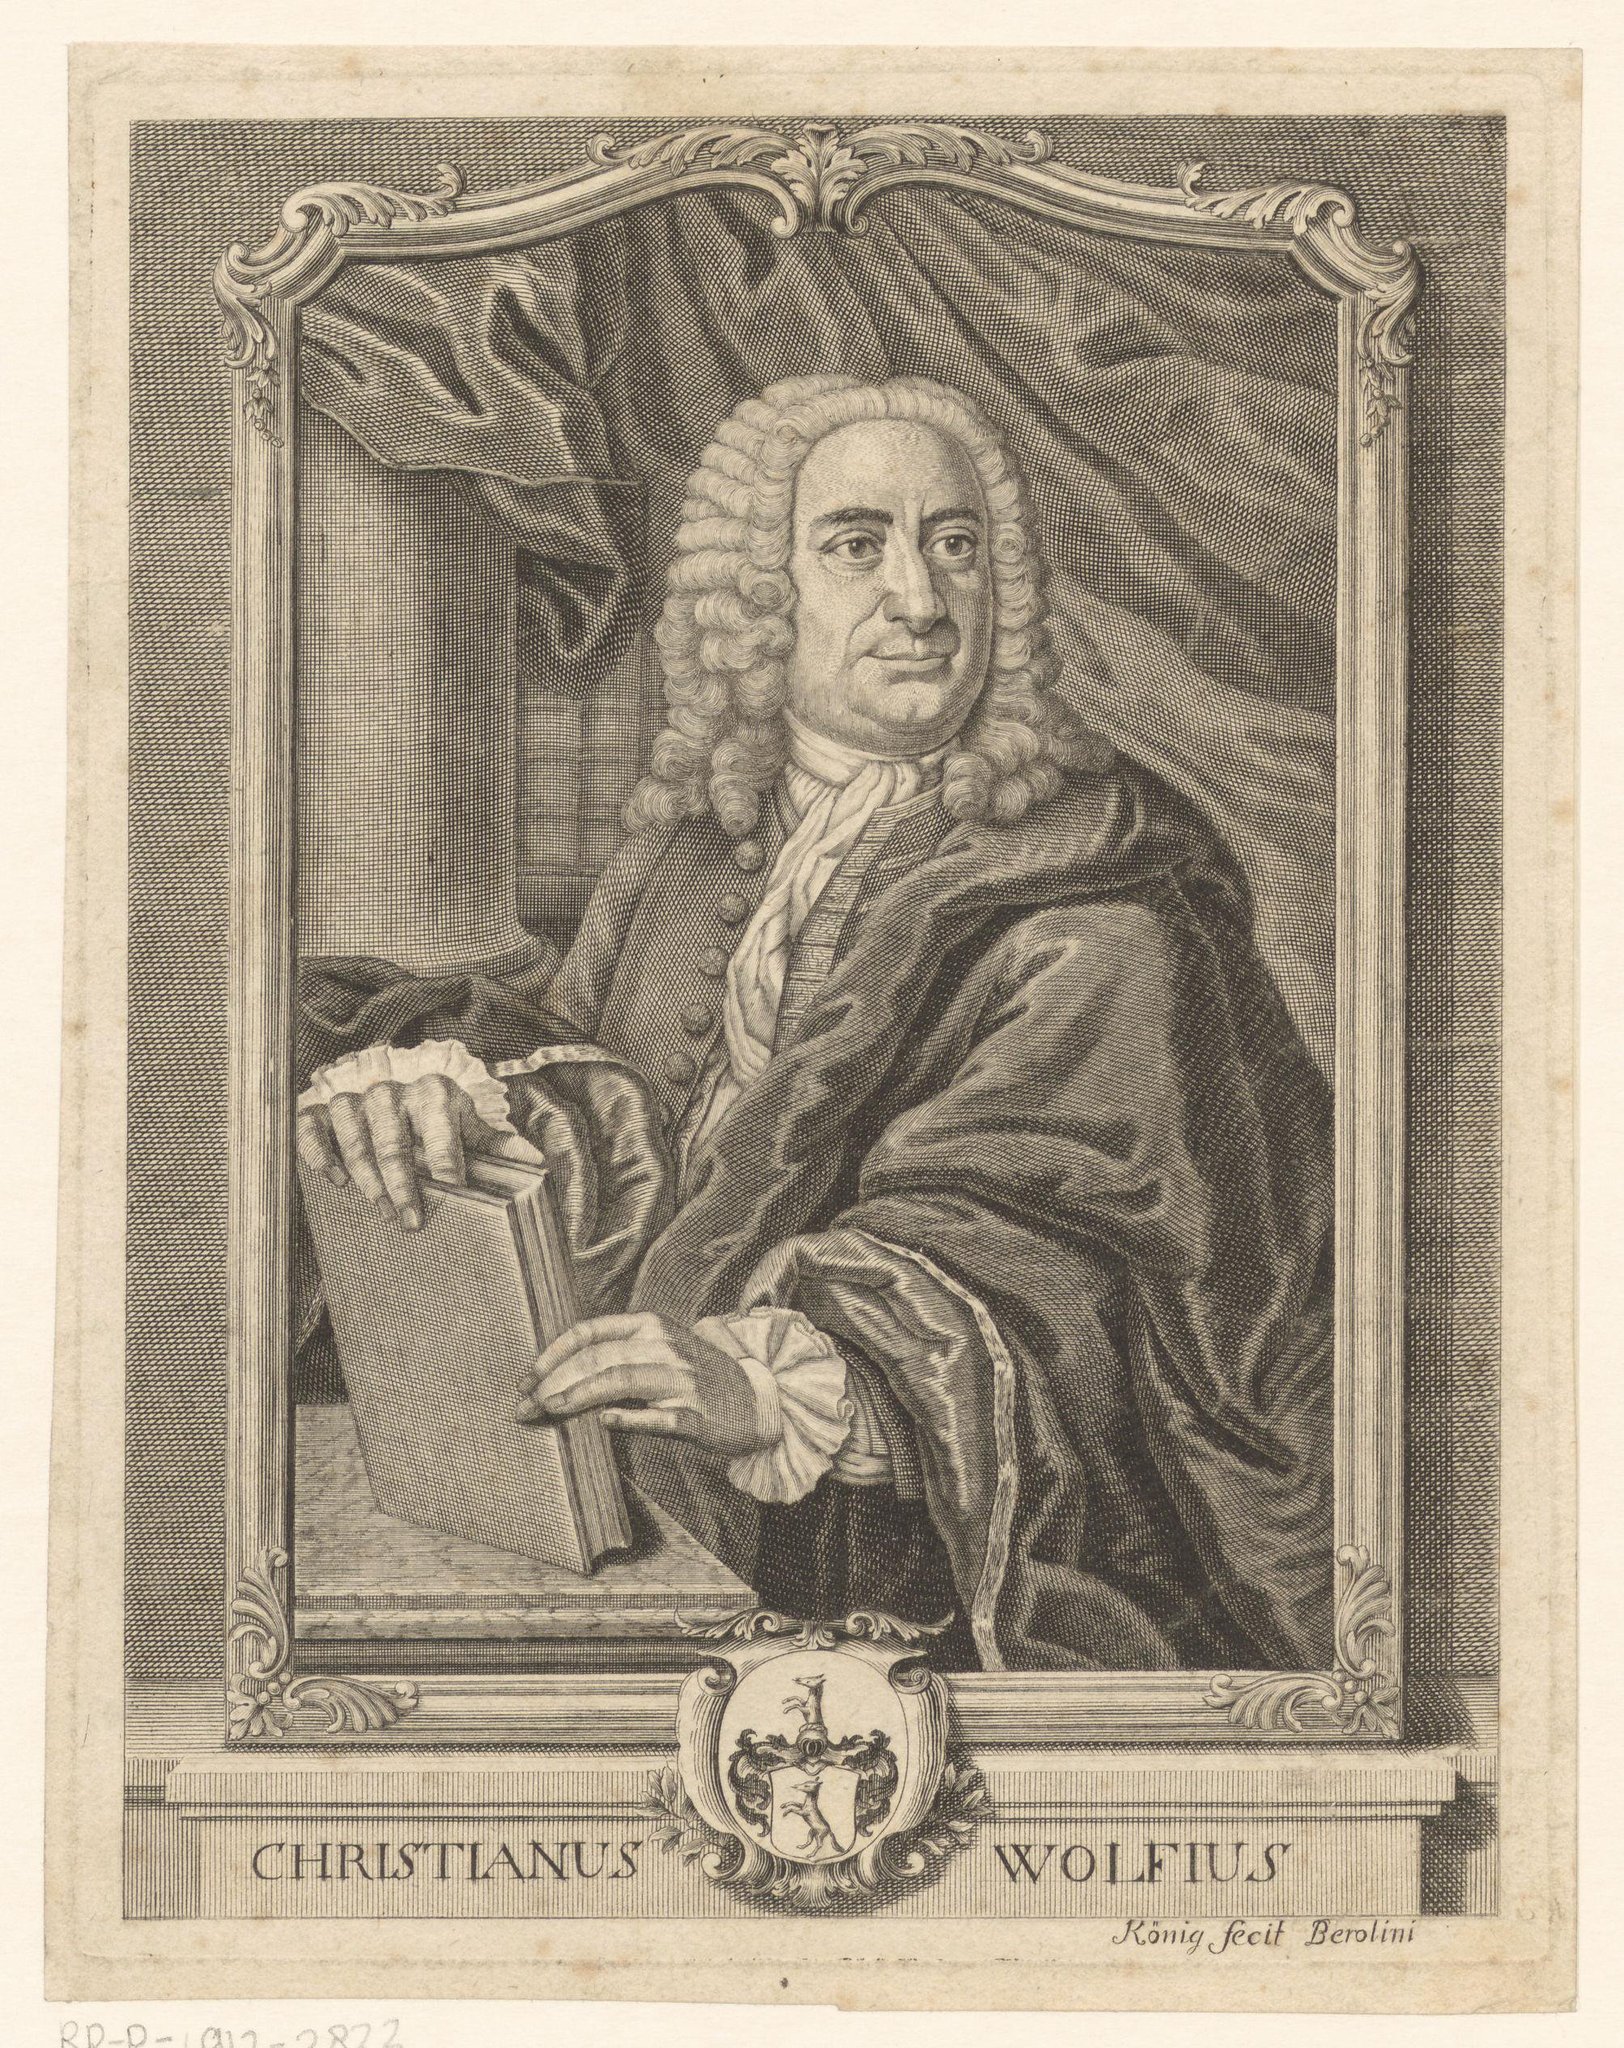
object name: print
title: Portret van Christian Wolff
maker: anton balthazar könig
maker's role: print maker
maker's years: 1693-1773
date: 1711-1773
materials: paper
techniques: engraving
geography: berlin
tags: historical persons, mathematics (+ portrait of scholar, scientist), scholar, philosopher (+ portrait of scholar, scientist)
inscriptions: collector's mark: Lugt 2228, annotation